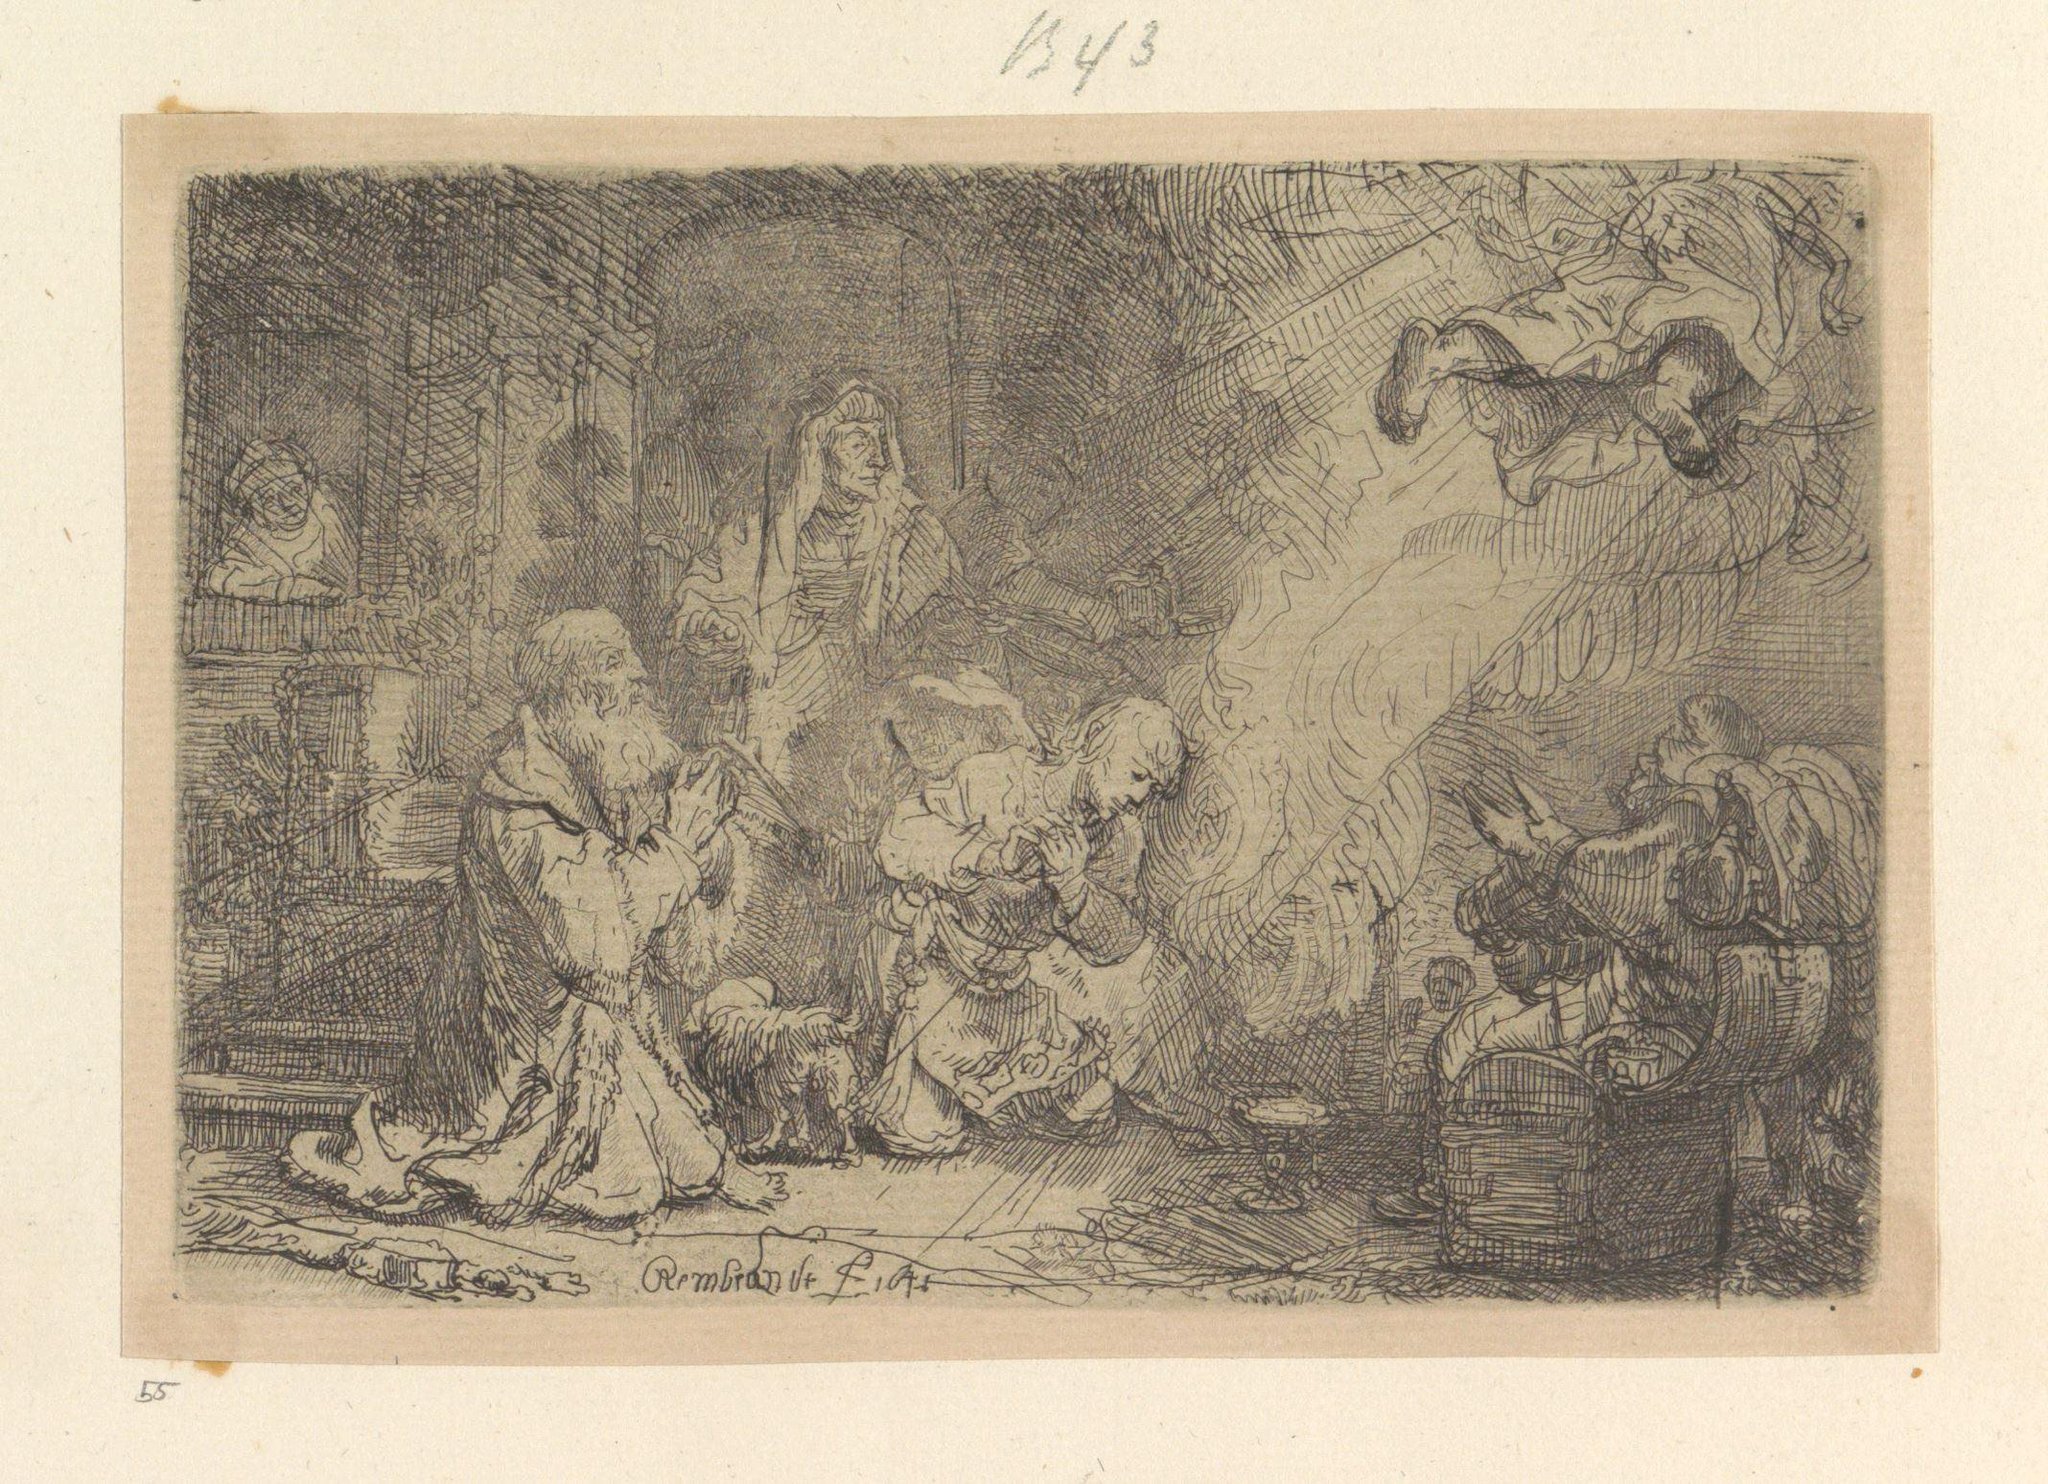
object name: print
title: Engel verlaat Tobias en zijn gezin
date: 1641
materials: paper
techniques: drypoint, etching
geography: paris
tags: tobias and the angel raphael travelling, accompanied by tobias' dog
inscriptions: date